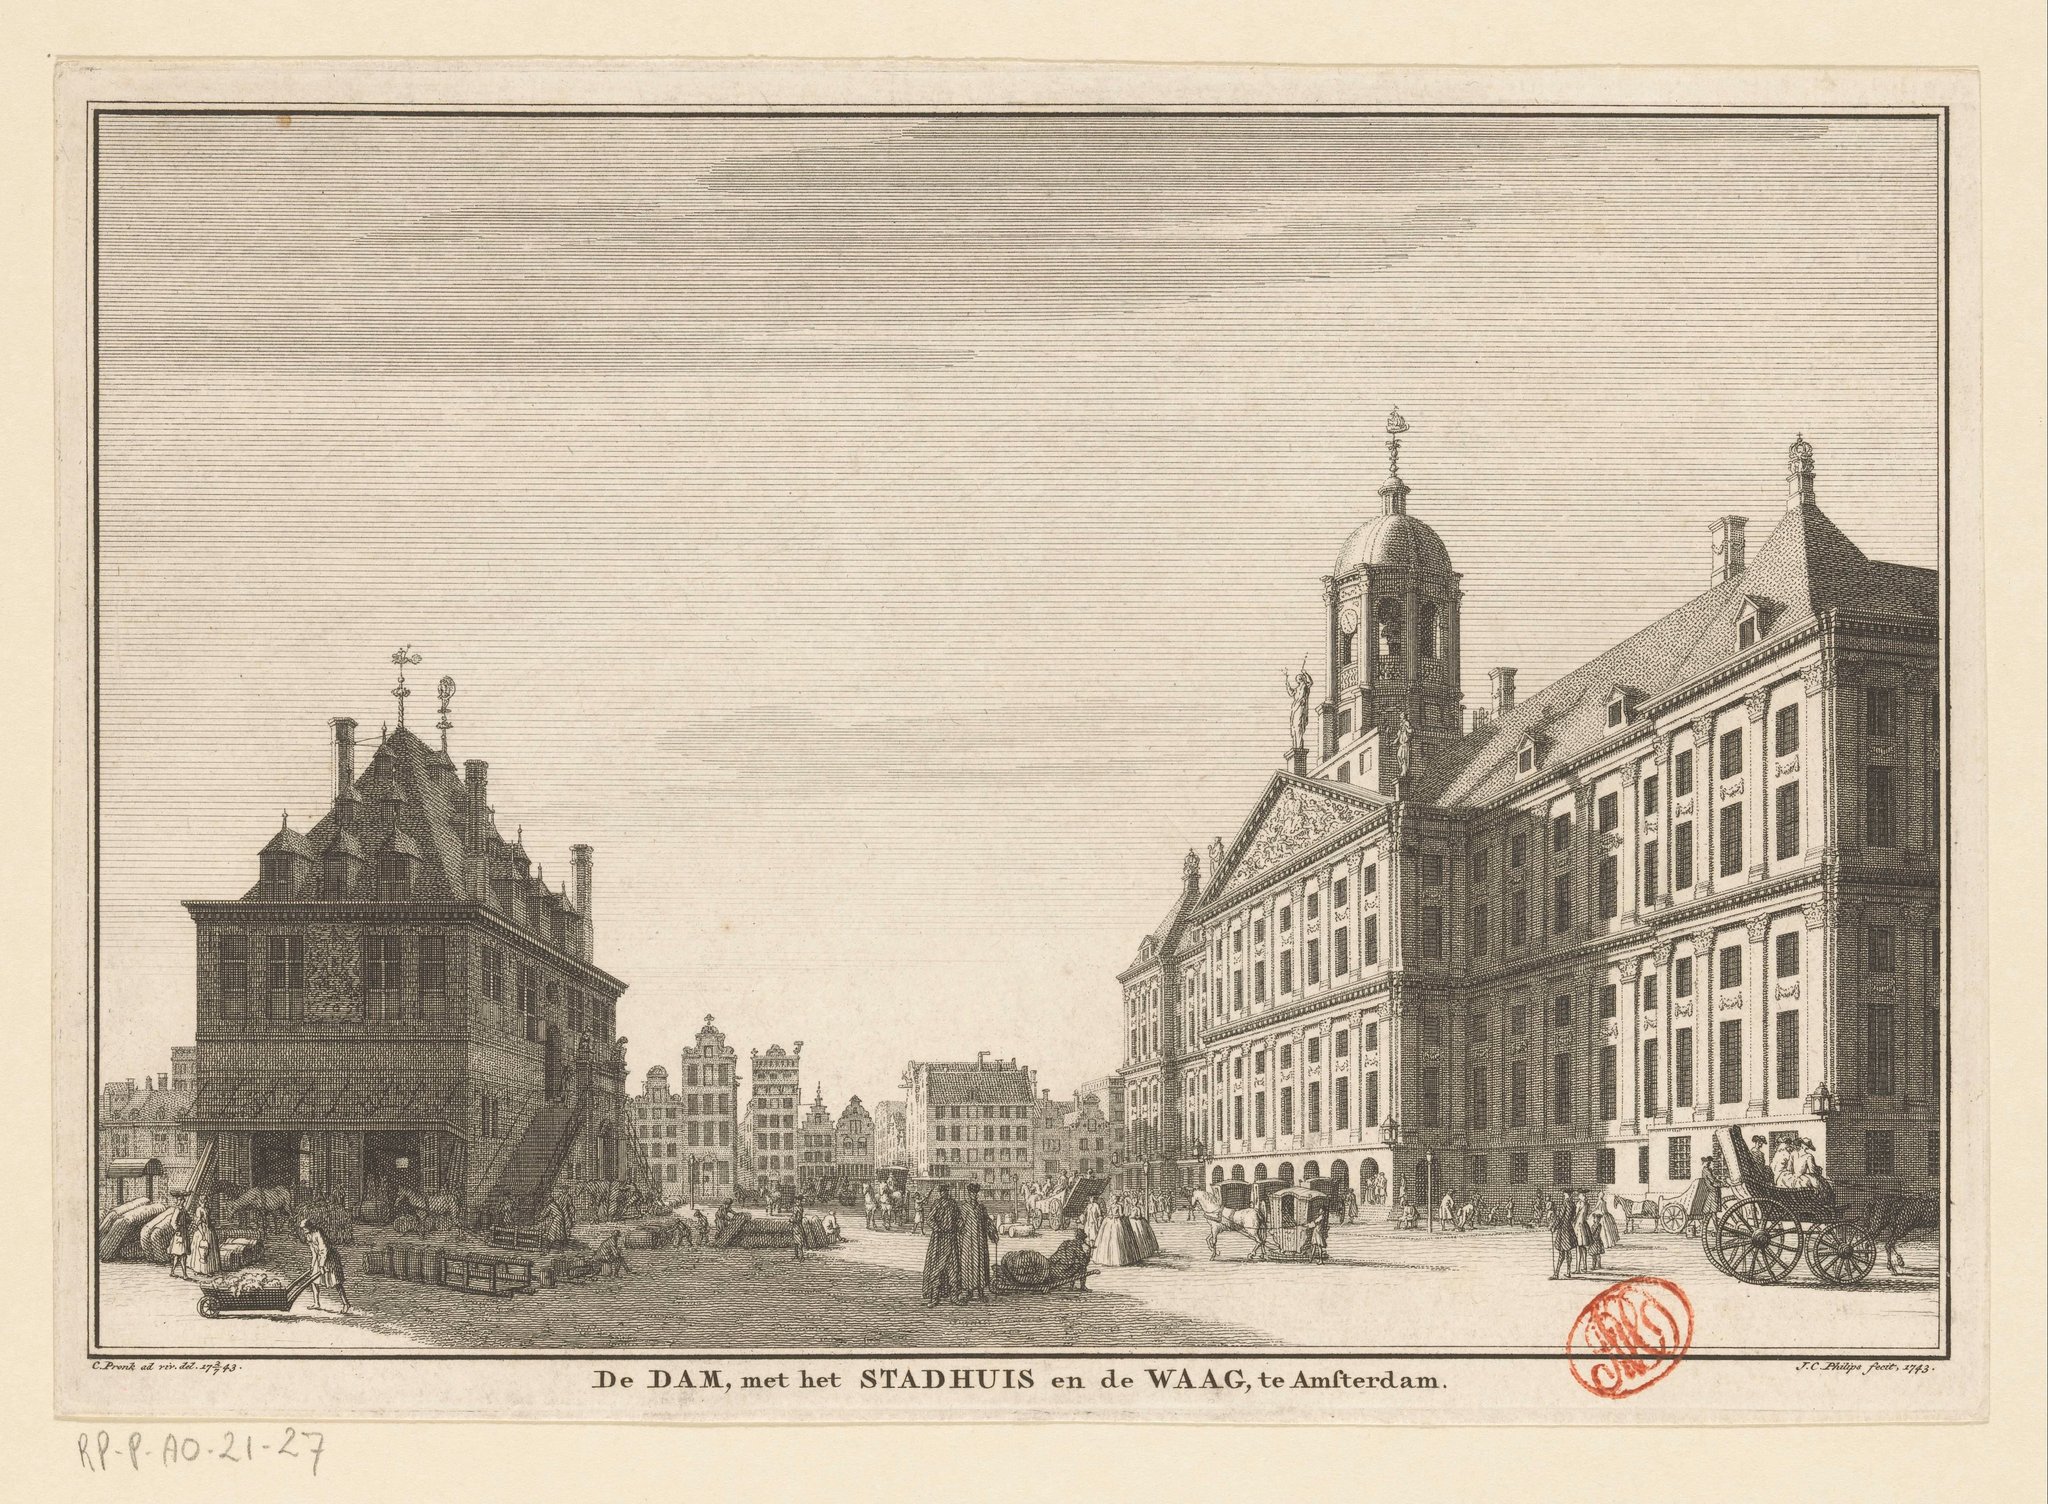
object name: book illustration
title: De Dam, met het Stadhuis en de Waag, te Amsterdam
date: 1743-1744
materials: paper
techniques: engraving, etching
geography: amsterdam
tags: townhall, weigh-house, square, place, circus, etc. (+ city(-scape) with figures, staffage)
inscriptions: collector's mark: Lugt 195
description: Prent ook gebruik in: Wagenaar, Jan. Tegenwoordige staat der Vereenigde Nederlanden, vyfde deel. Behelzende het vervolg der beschrijvinge van Holland. Met naauwkeurige plans der steden en printverbeeldingen versierd / Hedendaagsche historie, of tegenwoordige staat van alle volkeren; XVde deel (…). Amsterdam: Isaak Tirion, 1744. Markering rechtsboven (Vereen. Nederl. V Deel, Bladz. 28.) afgedekt tijdens drukken.